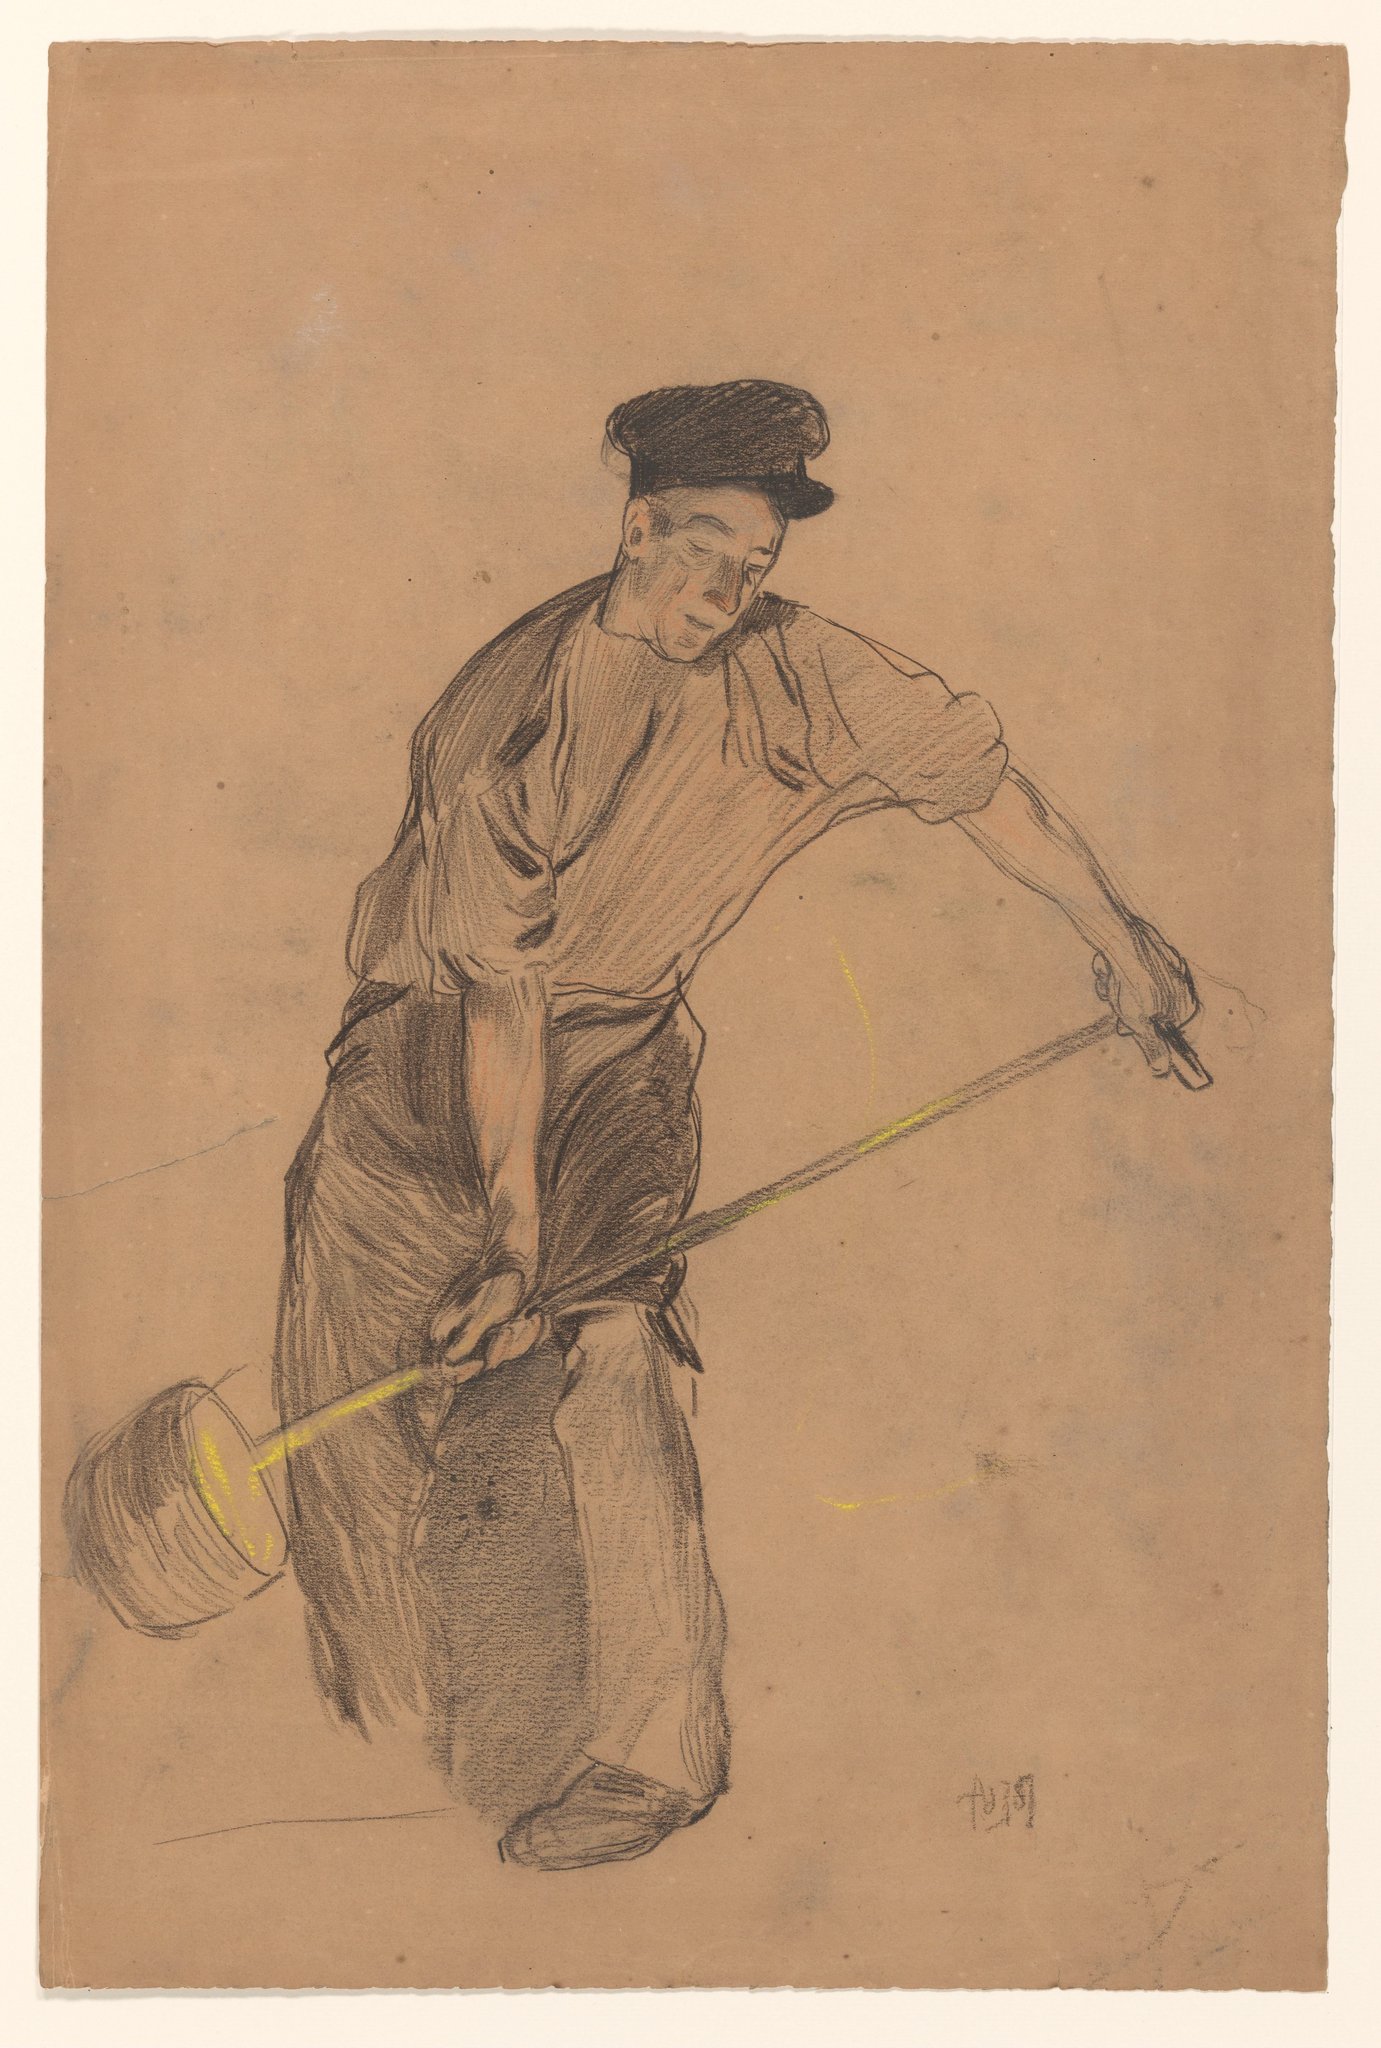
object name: drawing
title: Arbeider in staalfabriek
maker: pieter de josselin de jong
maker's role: draughtsman, painter, print maker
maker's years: 1861-1906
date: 1871-1906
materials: chalk, paper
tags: iron and steel industry (+ men (labourers))